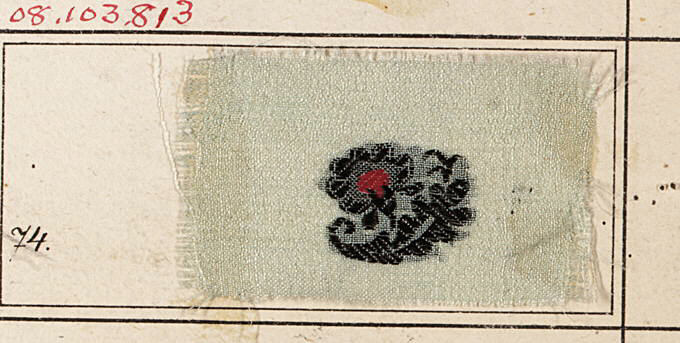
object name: ribbon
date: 1701-1900